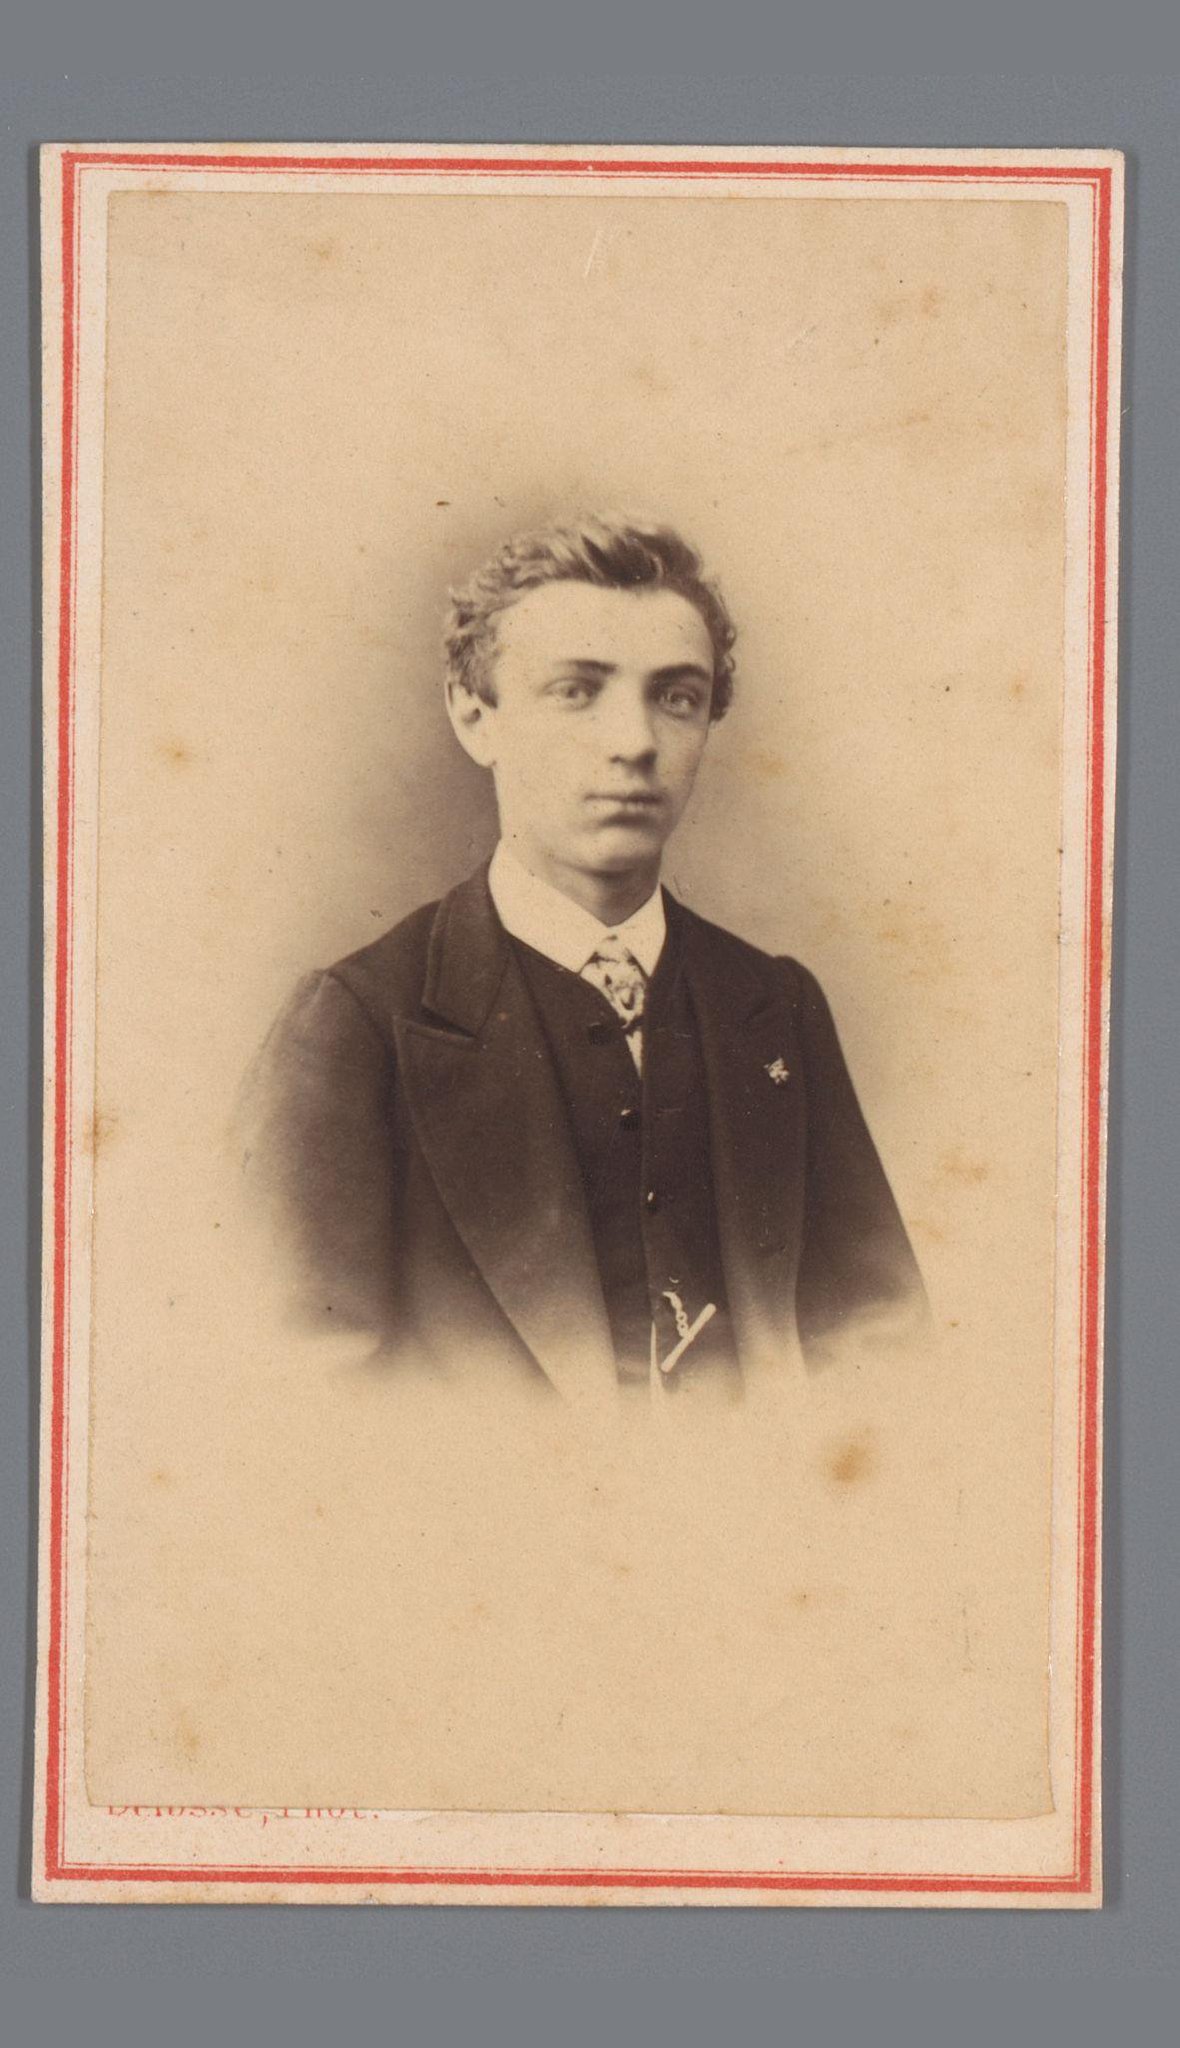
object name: carte de visite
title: Portret van een onbekende jonge man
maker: achille joseph défossé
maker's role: fotograaf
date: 1865-1879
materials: cardboard, paper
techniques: albumen print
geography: paris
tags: youth, adolescent, anonymous historical person portrayed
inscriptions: address: ‘19, Boulevart St Denis/ (Maison du Nègre)/ Paris’